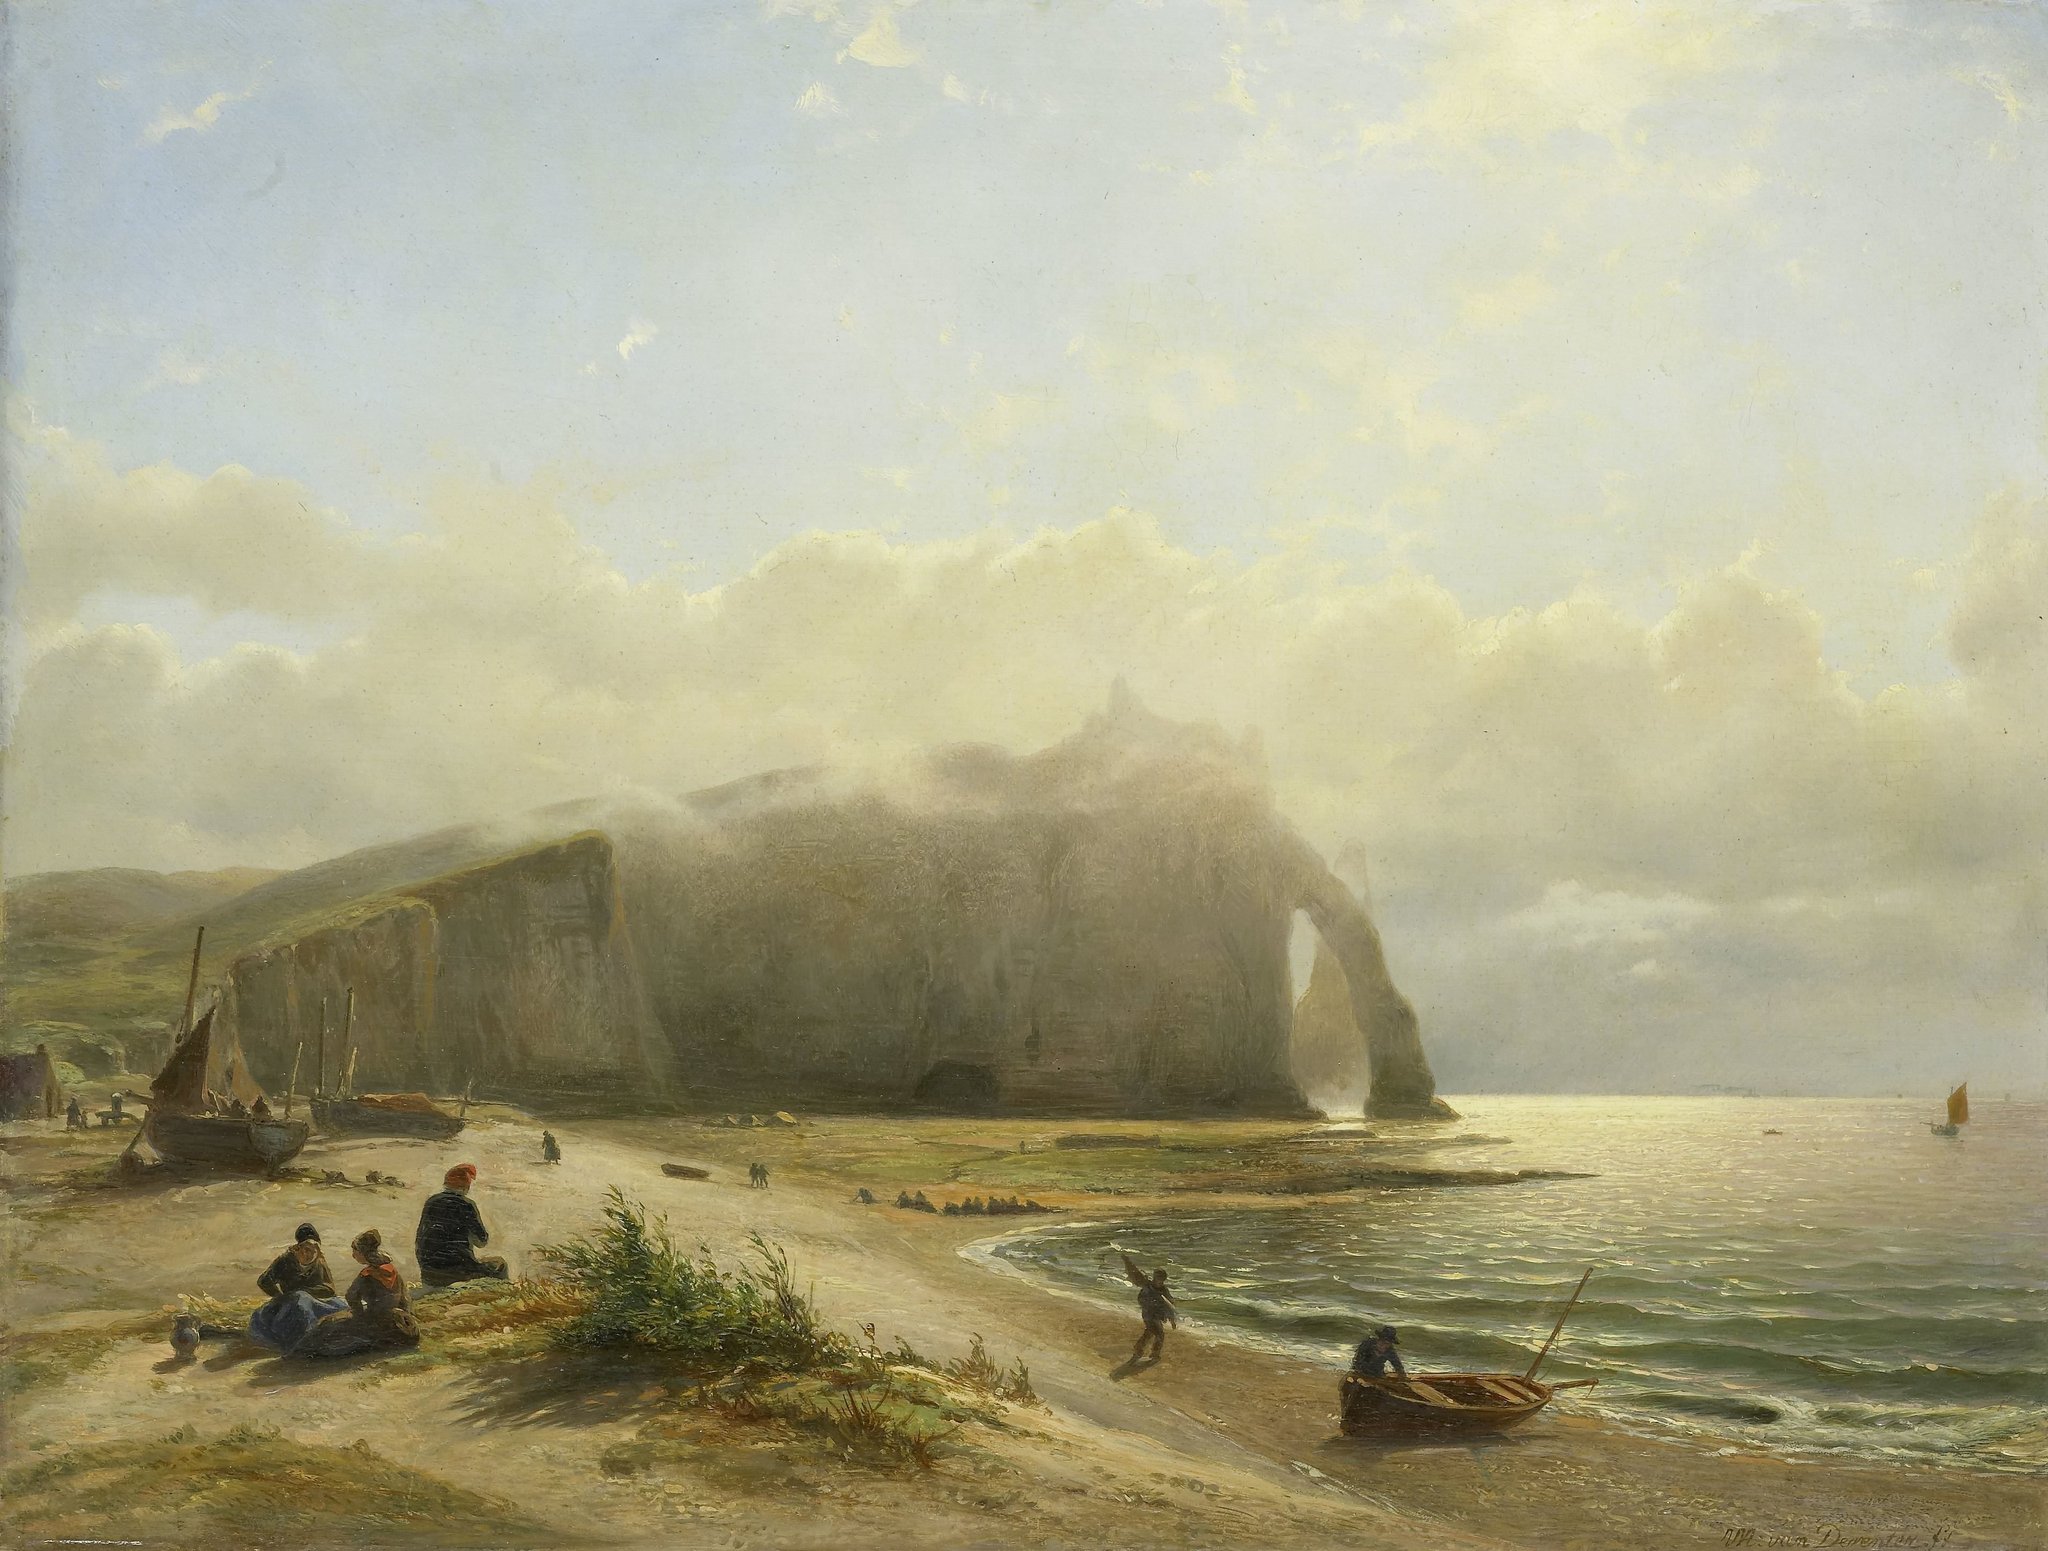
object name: painting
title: Seascape near the Coast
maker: willem anthonie van deventer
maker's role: draughtsman, painter, print maker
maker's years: 1824-1893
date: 1845-1880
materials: oil, panel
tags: rocky coast, beach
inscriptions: signature: ‘WA van Deventer. ft’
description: Zeegezicht aan de kust. Gezicht op het strand en de krijtrotsen bij Etretat in Normandië.